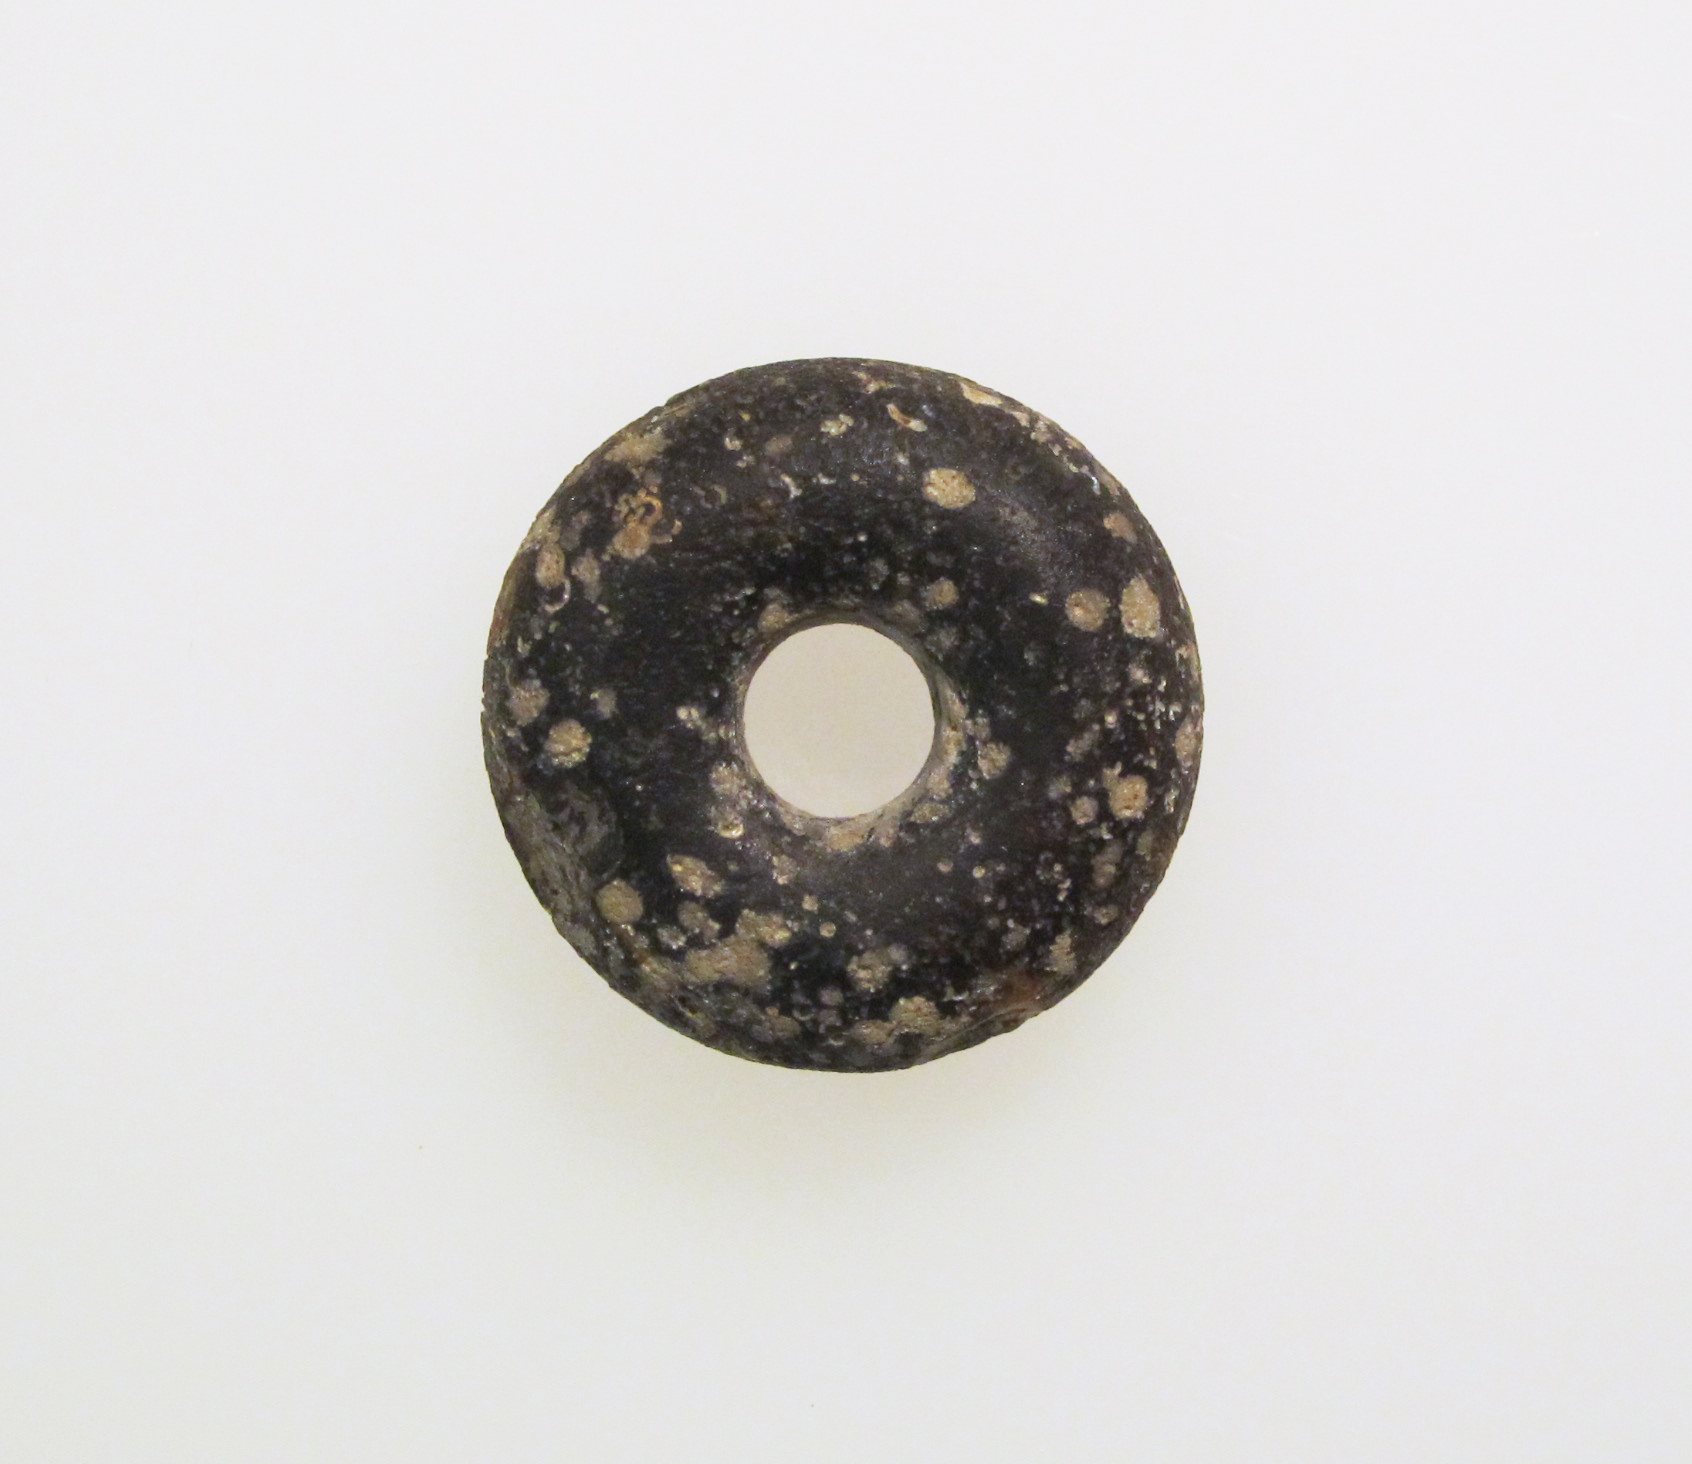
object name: bead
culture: roman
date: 670 BCE-330 CE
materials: glass